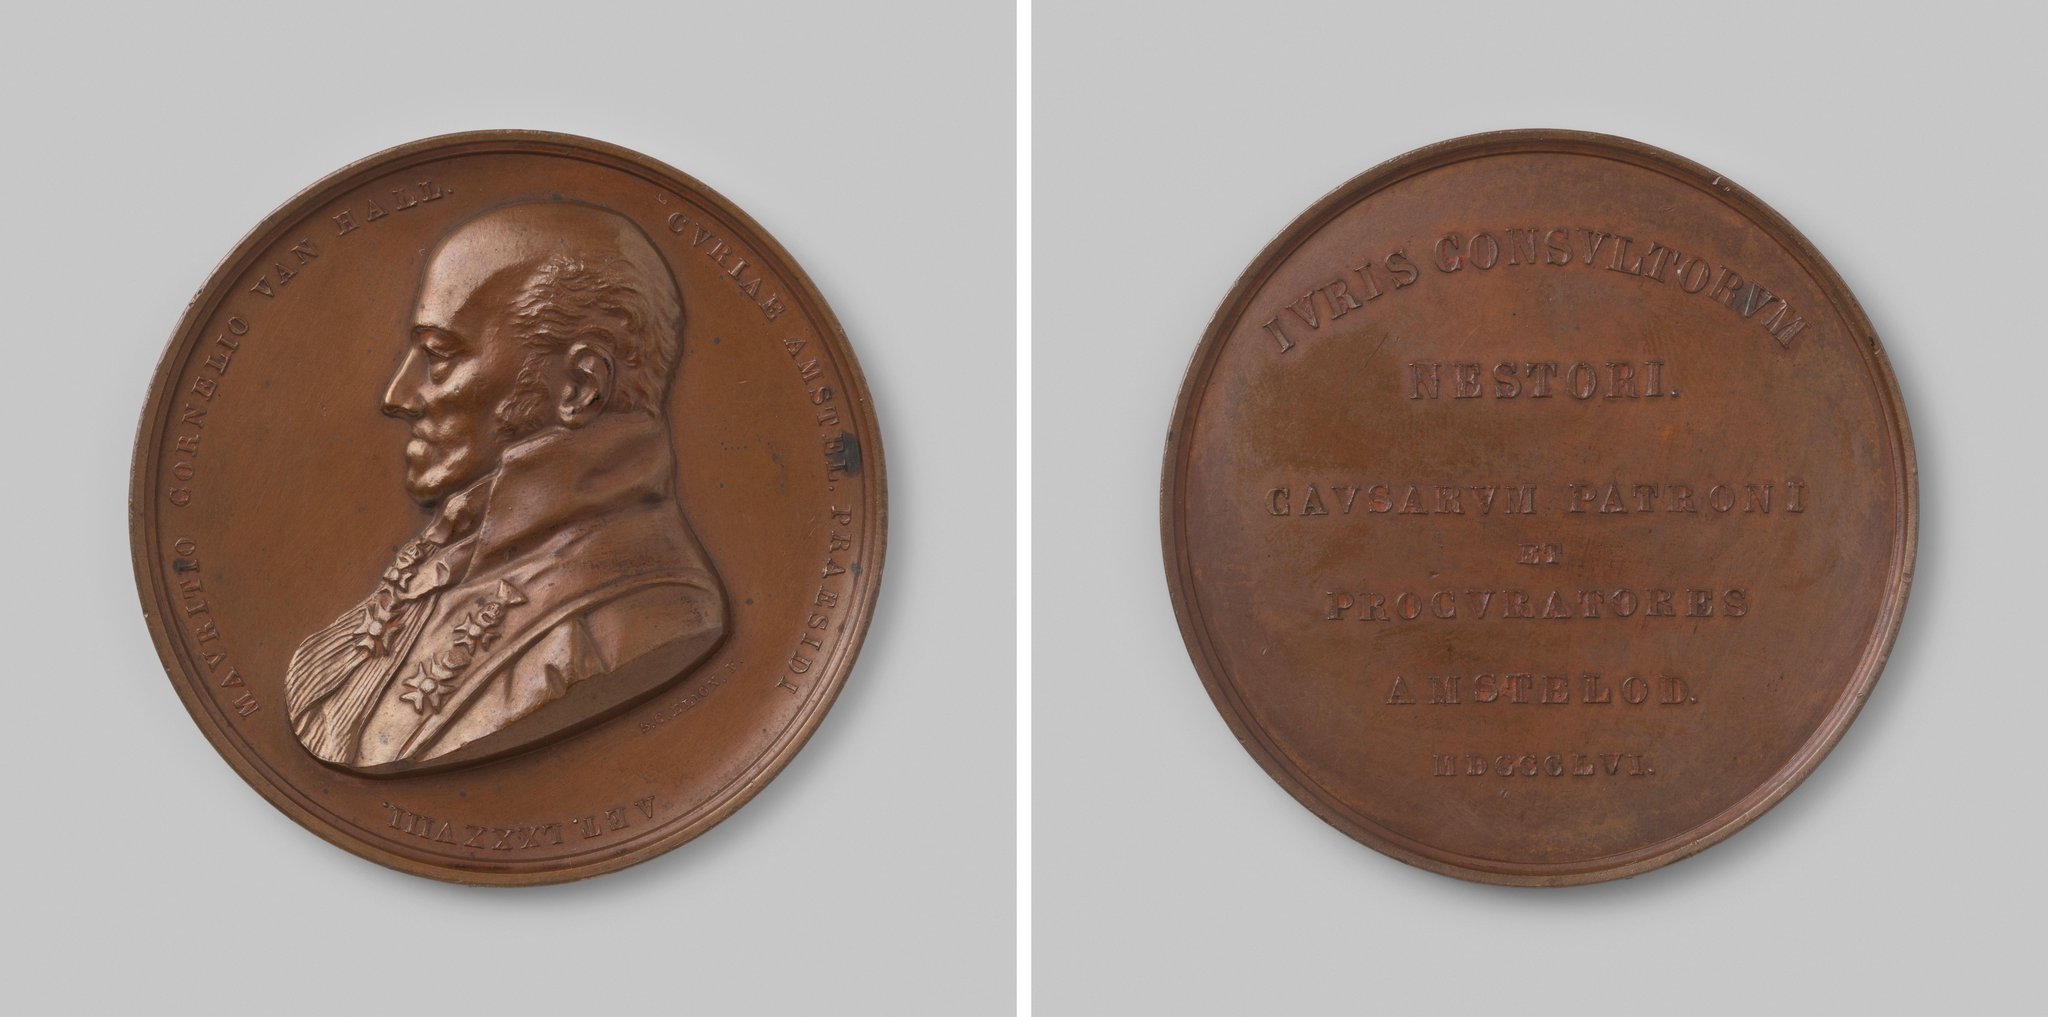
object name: honorary medal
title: Maurits Cornelis van Hall, voorzitter van de arrondissementsrechtbank te Amsterdam, penning aangeboden door de Amsterdamse advocaten en procureurs op zijn 88e verjaardag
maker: samuel cohen elion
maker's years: 1815-1880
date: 1856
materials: bronze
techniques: striking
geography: amsterdam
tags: amsterdam, maurits cornelis van hall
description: Bronzen penning. Voorzijde: borststuk man binnen omschrift. Keerzijde: opschrift